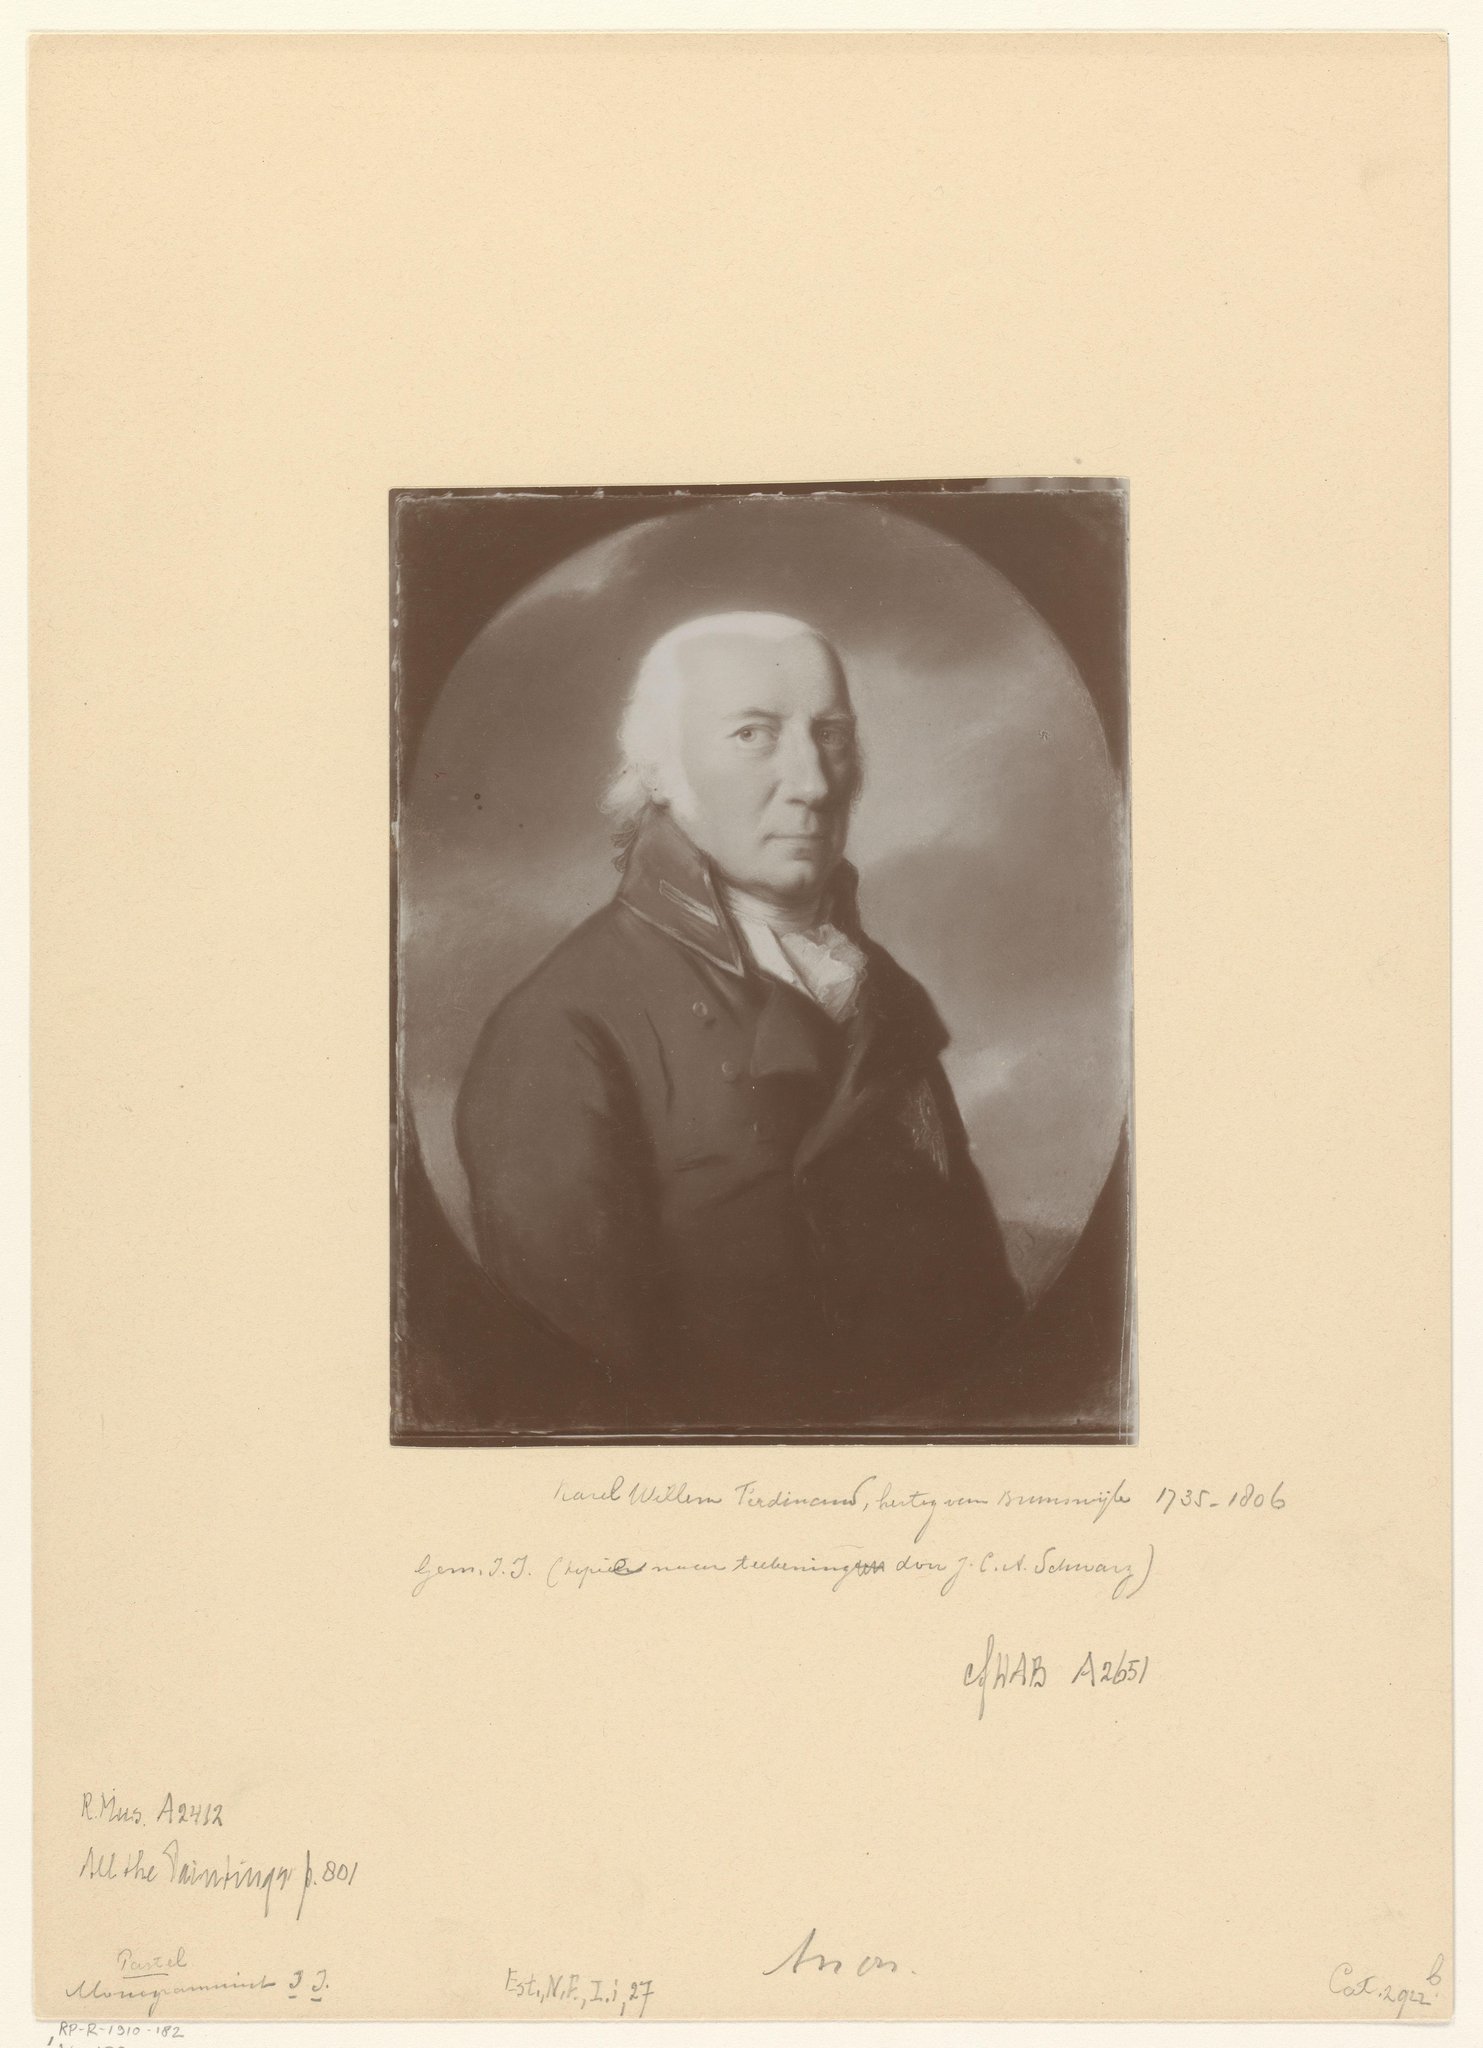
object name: reproduction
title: Fotoreproductie van een geschilderd portret van Karel Willem Ferdinand van Brunswijk-Wolfenbüttel, door Johann Heinrich Schröder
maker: koop remmerts semplonius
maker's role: draughtsman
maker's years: 1847-1915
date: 1894-1910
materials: paper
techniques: collodion silver print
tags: historical persons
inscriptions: collector's mark: Lugt 2228